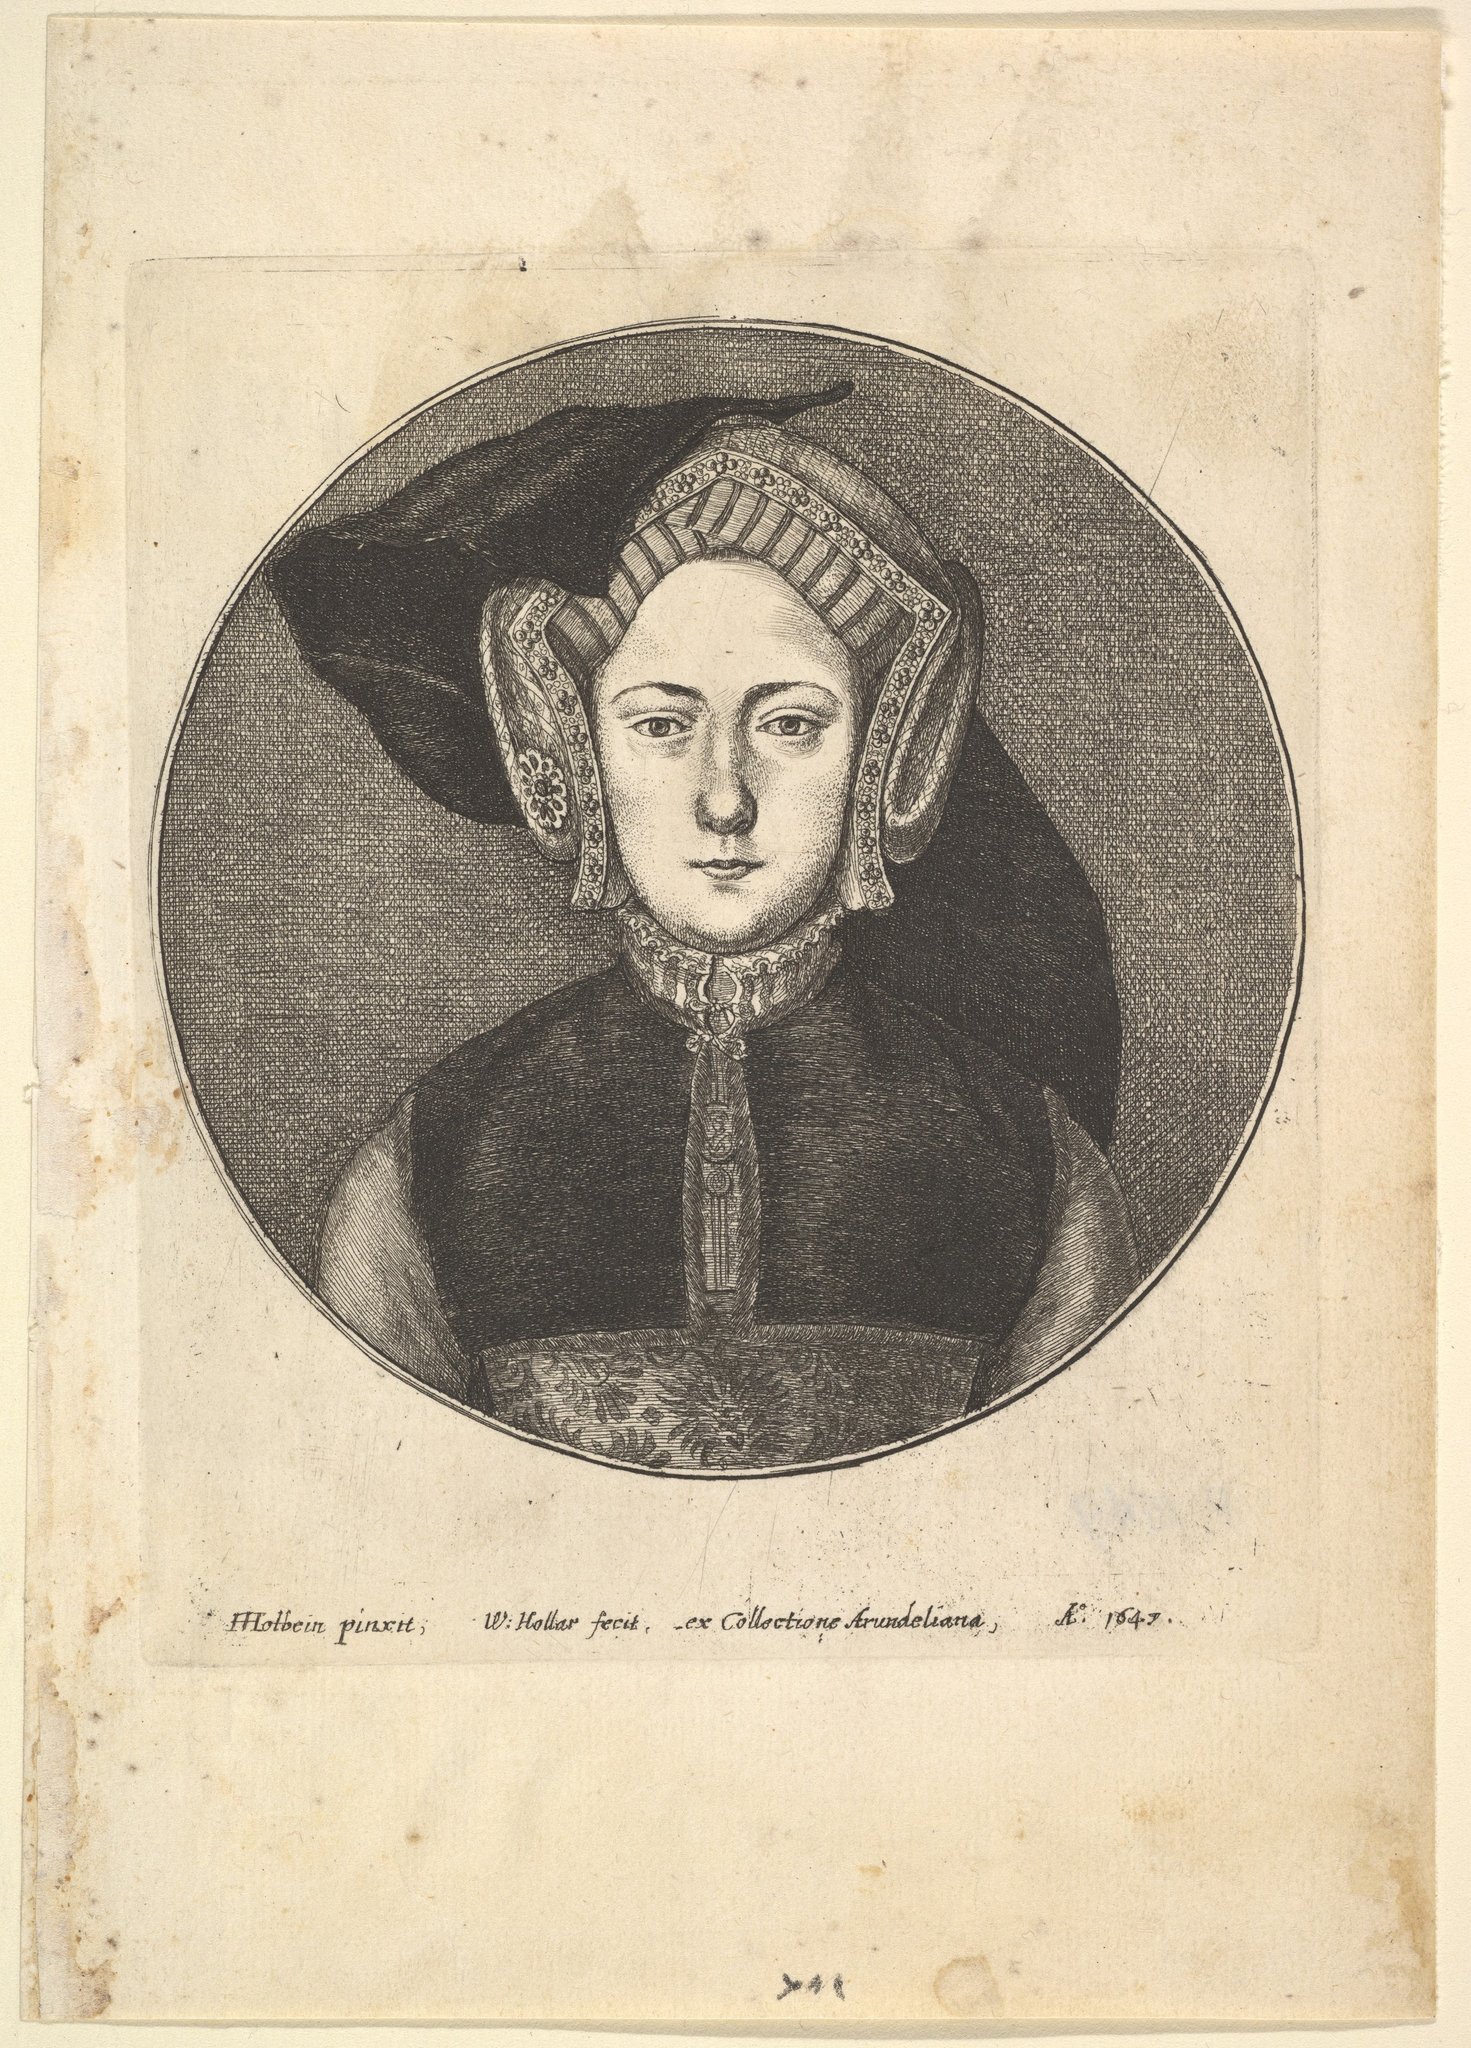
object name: print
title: Portrait of a Young Woman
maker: wenceslaus hollar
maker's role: artist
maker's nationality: bohemian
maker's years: 1607-1677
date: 1647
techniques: etching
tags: portraits,women